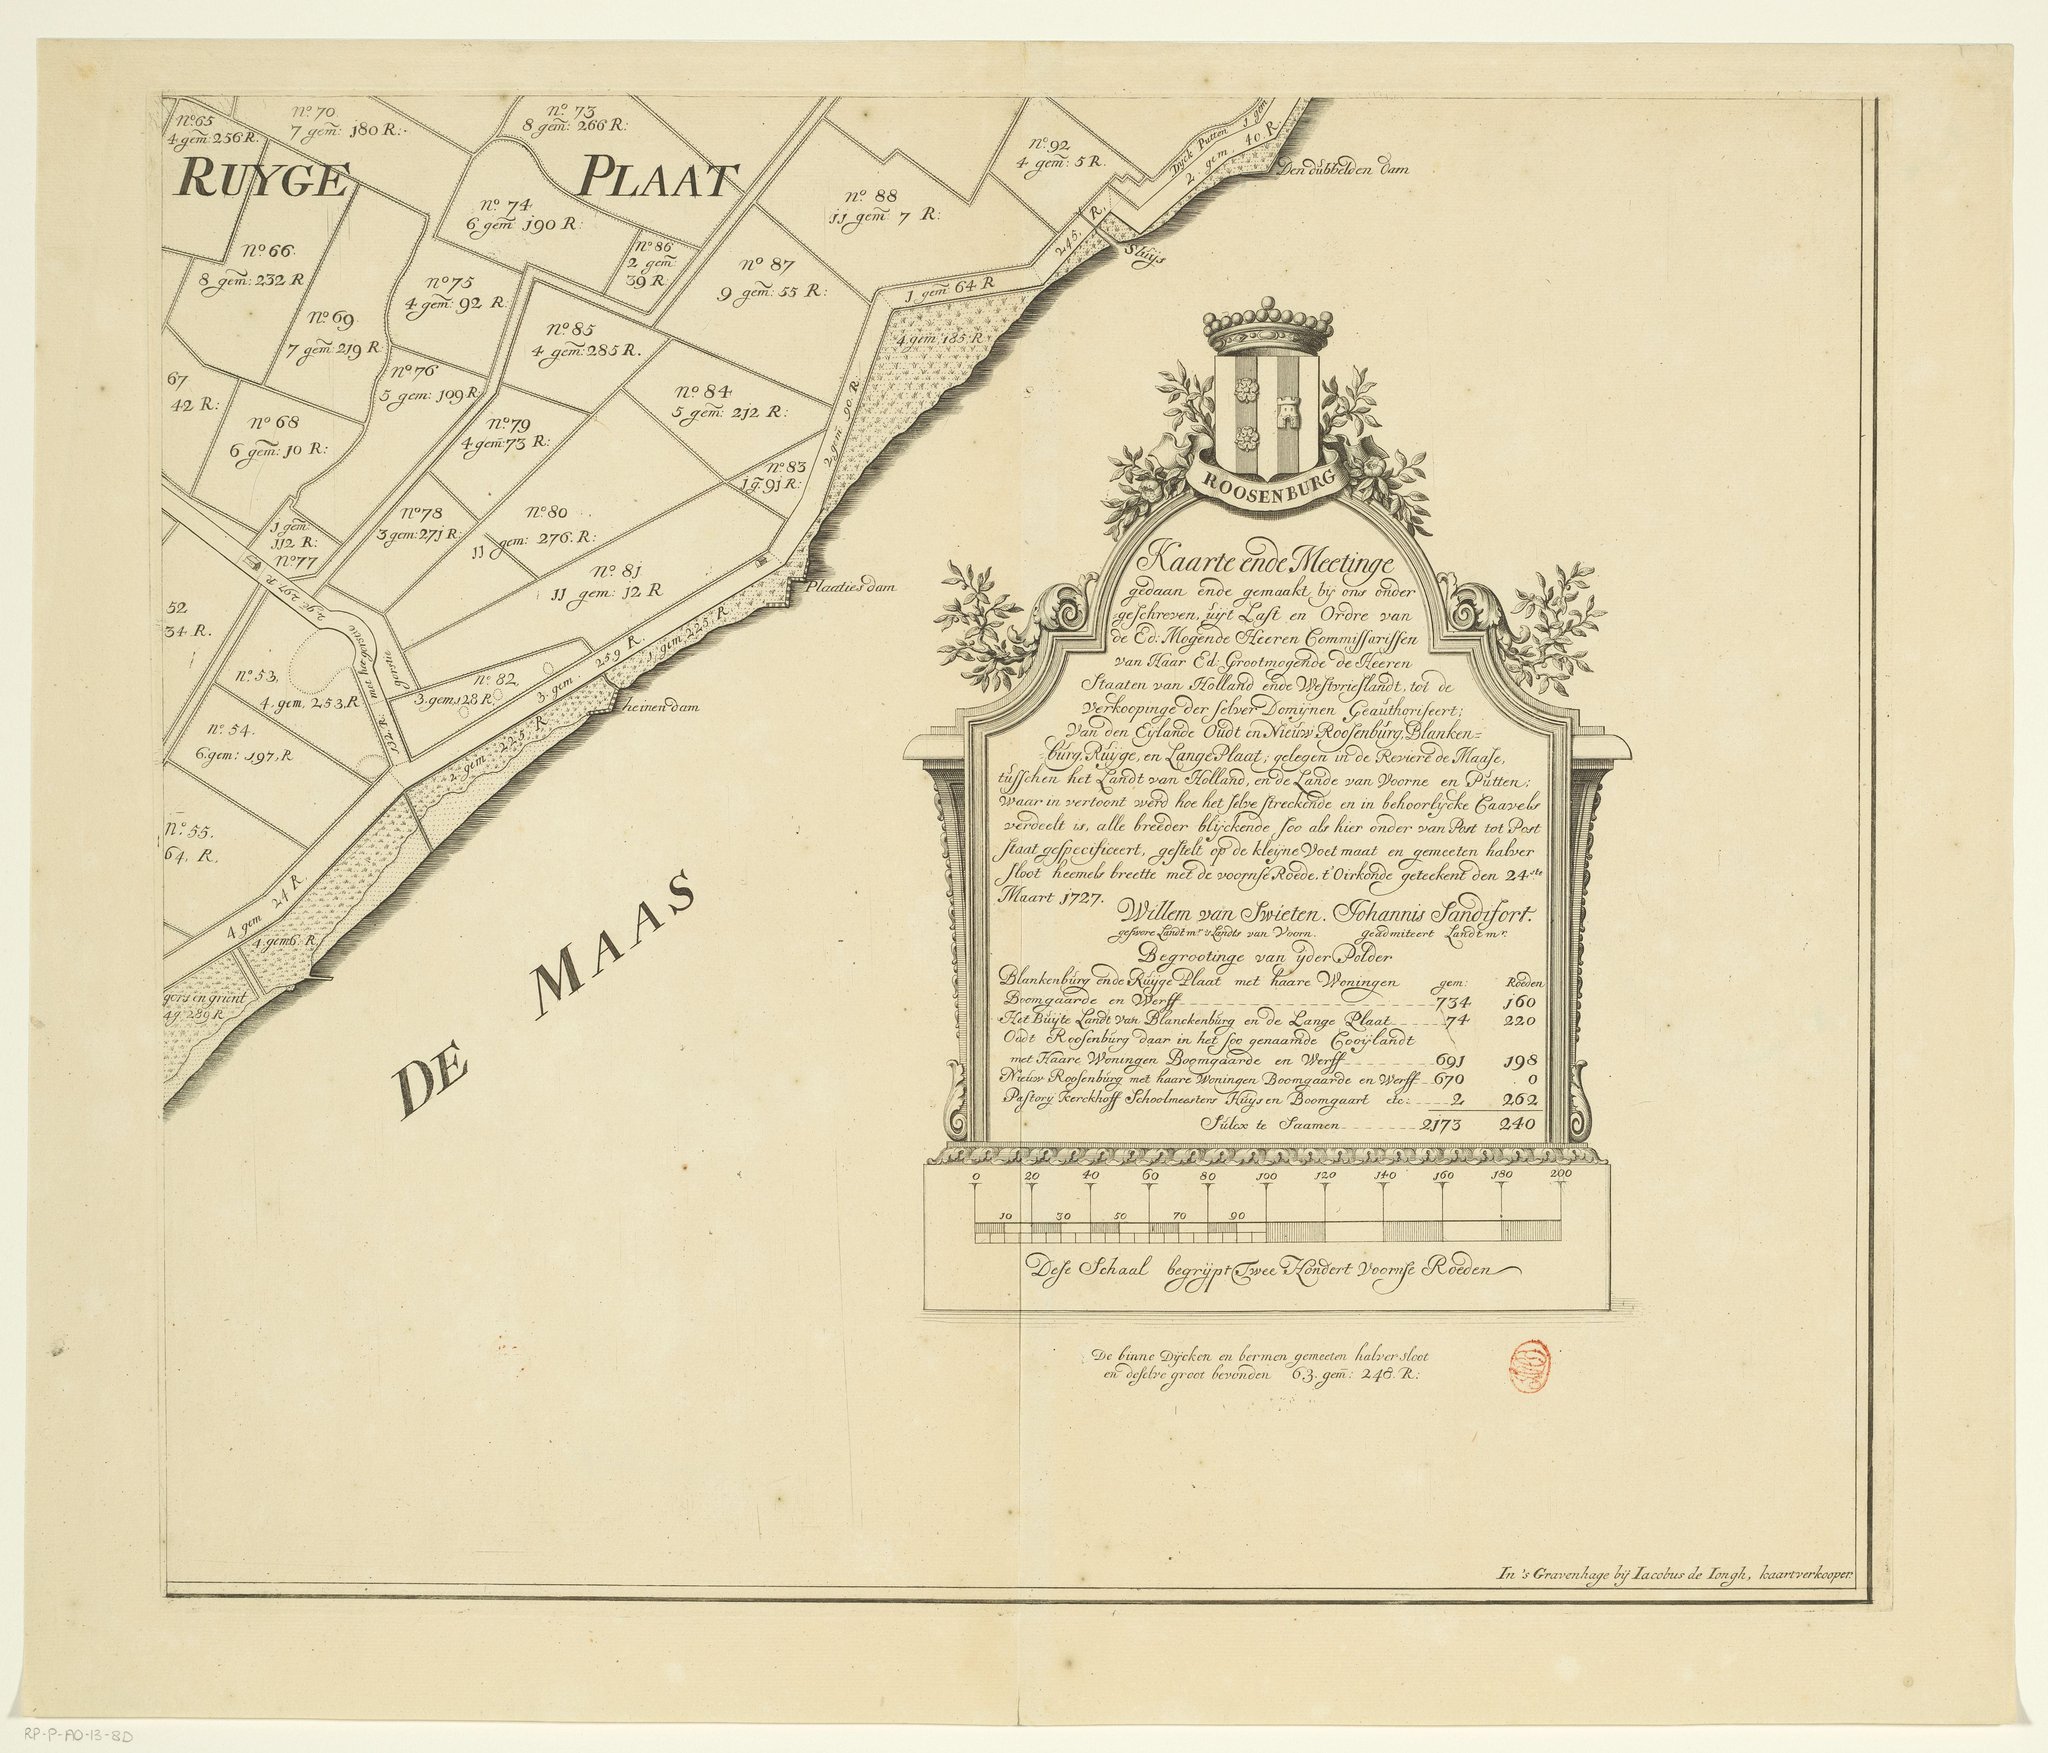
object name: print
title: Kaart van het eiland Rozenburg (vierde deel van onder)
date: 1727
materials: paper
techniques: engraving, etching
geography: the hague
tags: coat of arms (as symbol of the state, etc.) (+ city; municipal), maps of separate countries or regions, polder, reclaimed land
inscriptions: collector's mark: Lugt 195, collector's mark: Lugt 2228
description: Deel (vierde van onder) van een kaart van het eiland Rozenburg, bestaande uit acht delen.